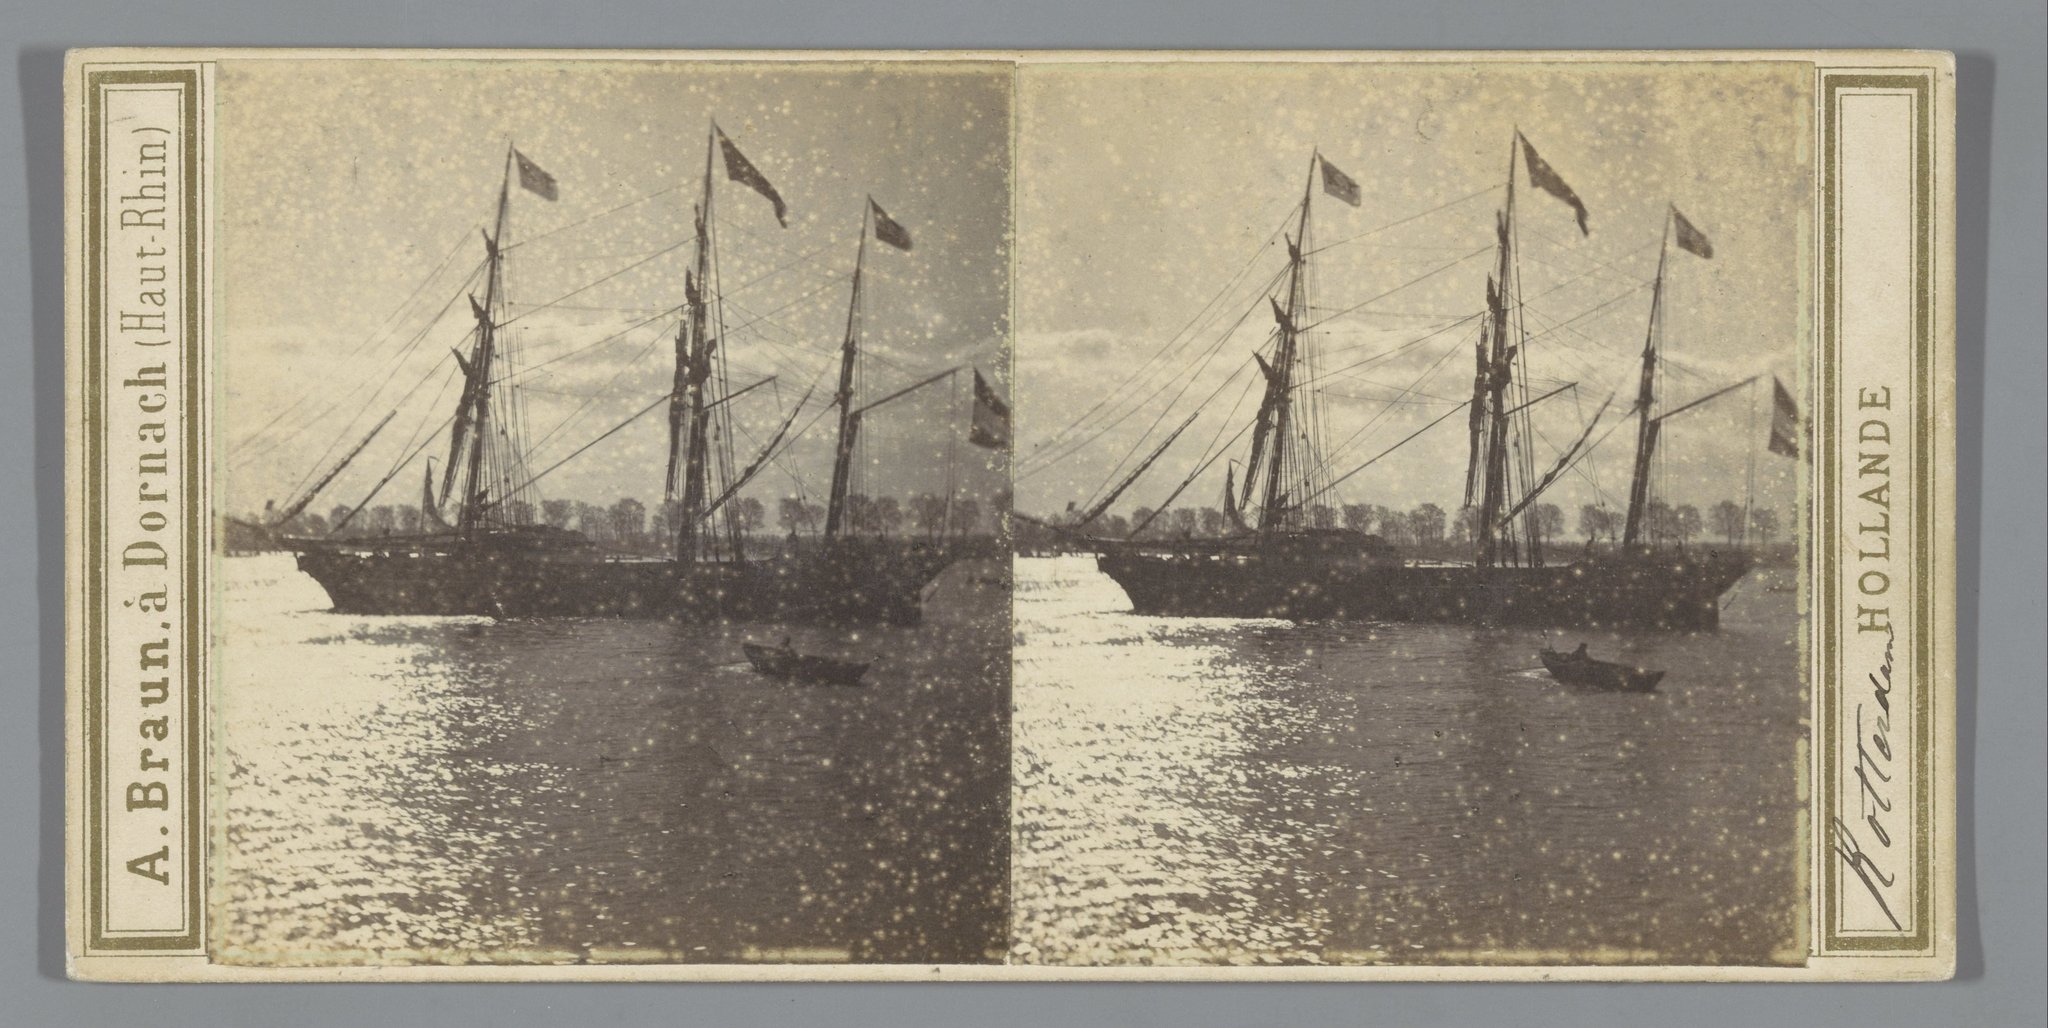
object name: stereograph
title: Hollande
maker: gaston braun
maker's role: fotograaf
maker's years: 1845-1928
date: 1864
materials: cardboard, paper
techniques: albumen print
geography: dornach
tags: ships (in general), rotterdam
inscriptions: number: ‘No 3795.’